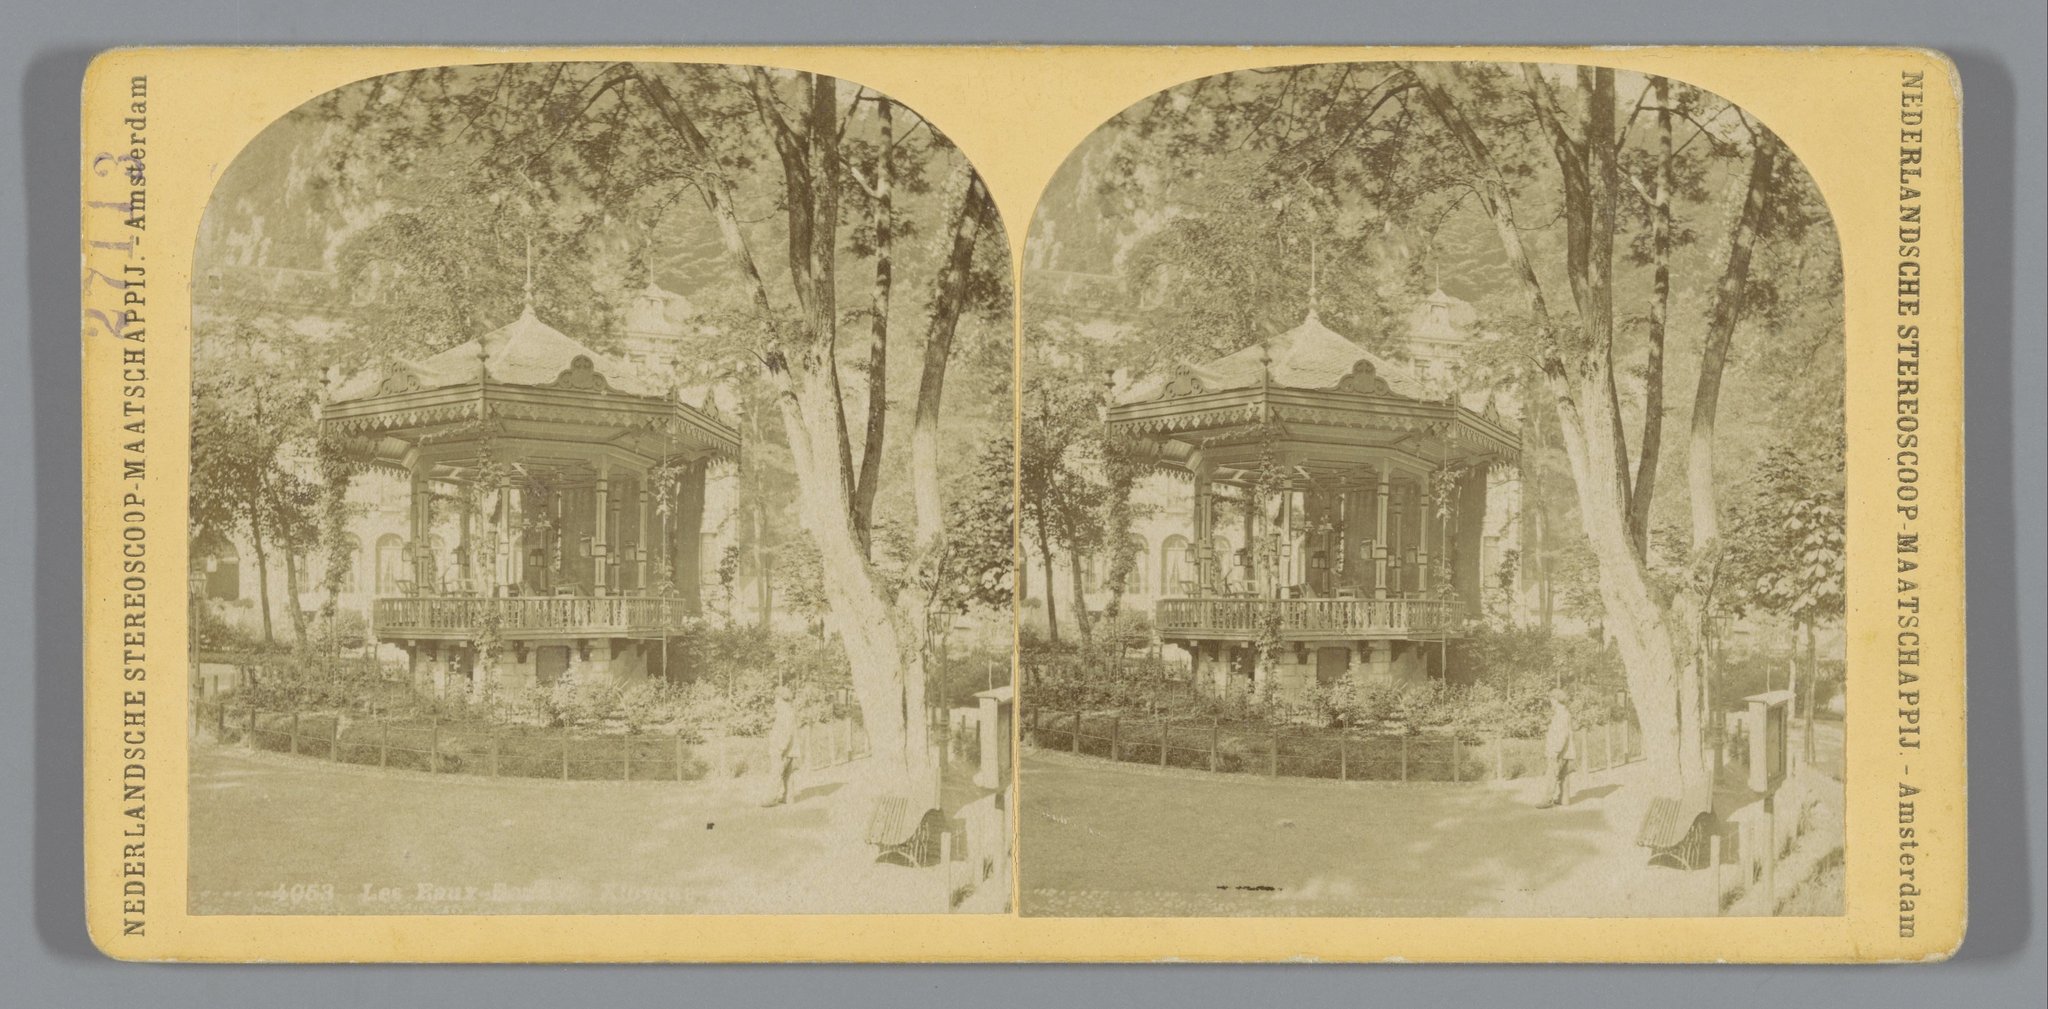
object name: stereograph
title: Les Eaux-Bonnes. Kiosque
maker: j.g. beers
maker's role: fotograaf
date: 1860-1880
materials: cardboard, photographic support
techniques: albumen print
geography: eaux-bonnes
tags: housing, façade (of house or building)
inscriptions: number: ‘4053’, number: ‘27113’